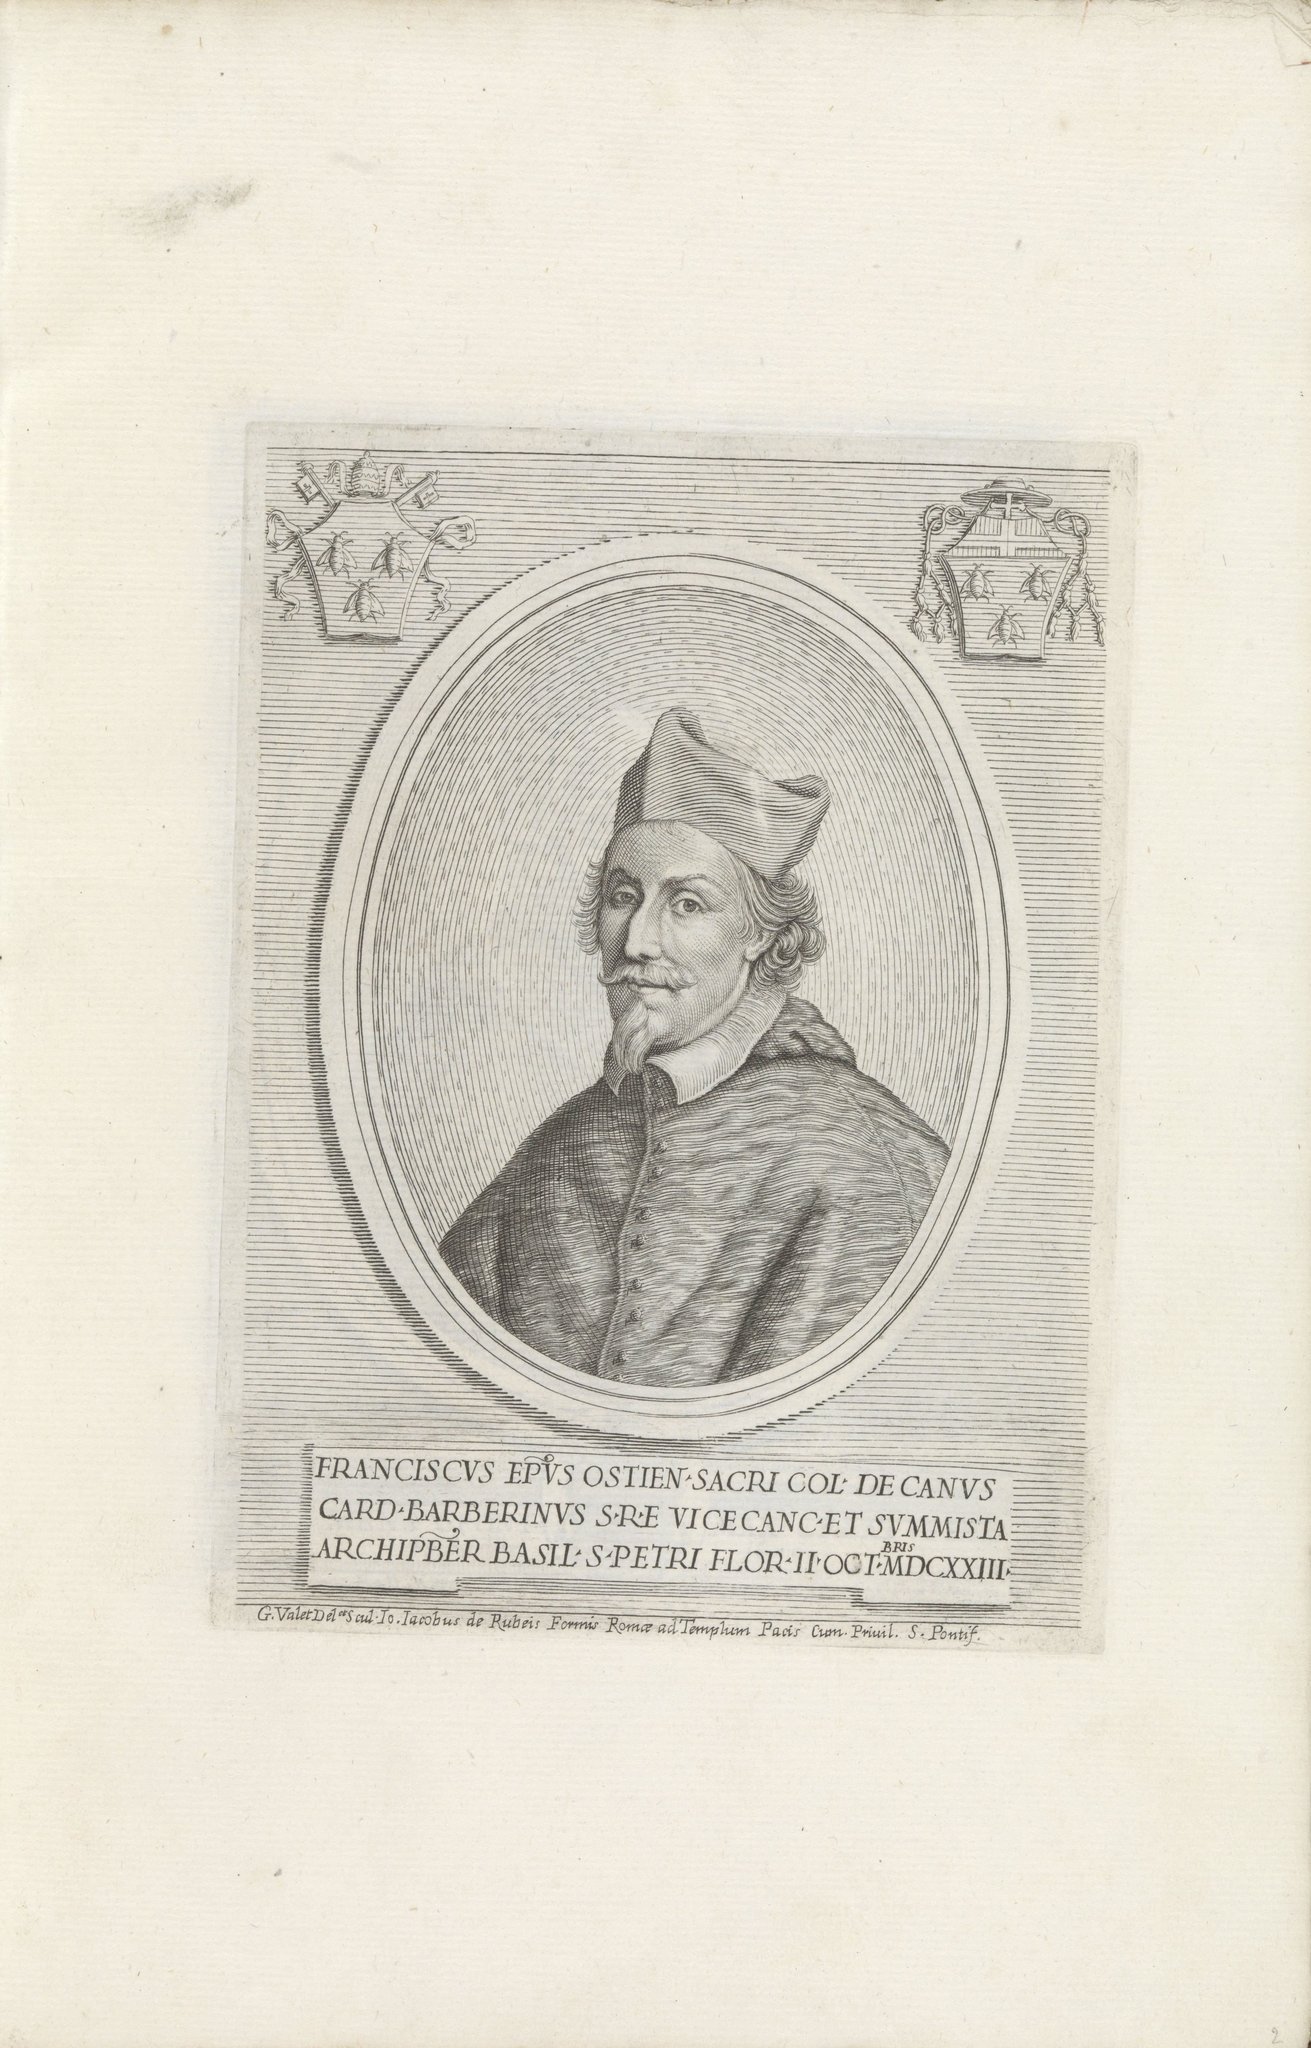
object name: print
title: Portret van kardinaal Francesco Barberini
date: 1658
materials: paper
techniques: engraving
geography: rome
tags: rome, francesco barberini (1597-1679), cardinal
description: Portret van kardinaal Francesco Barberini. Linksboven het wapen van paus Urbanus VIII en rechtsboven het wapen van kardinaal Barberini. Onderaan een onderschrift in het Latijn. Prent maakt deel uit van een album.